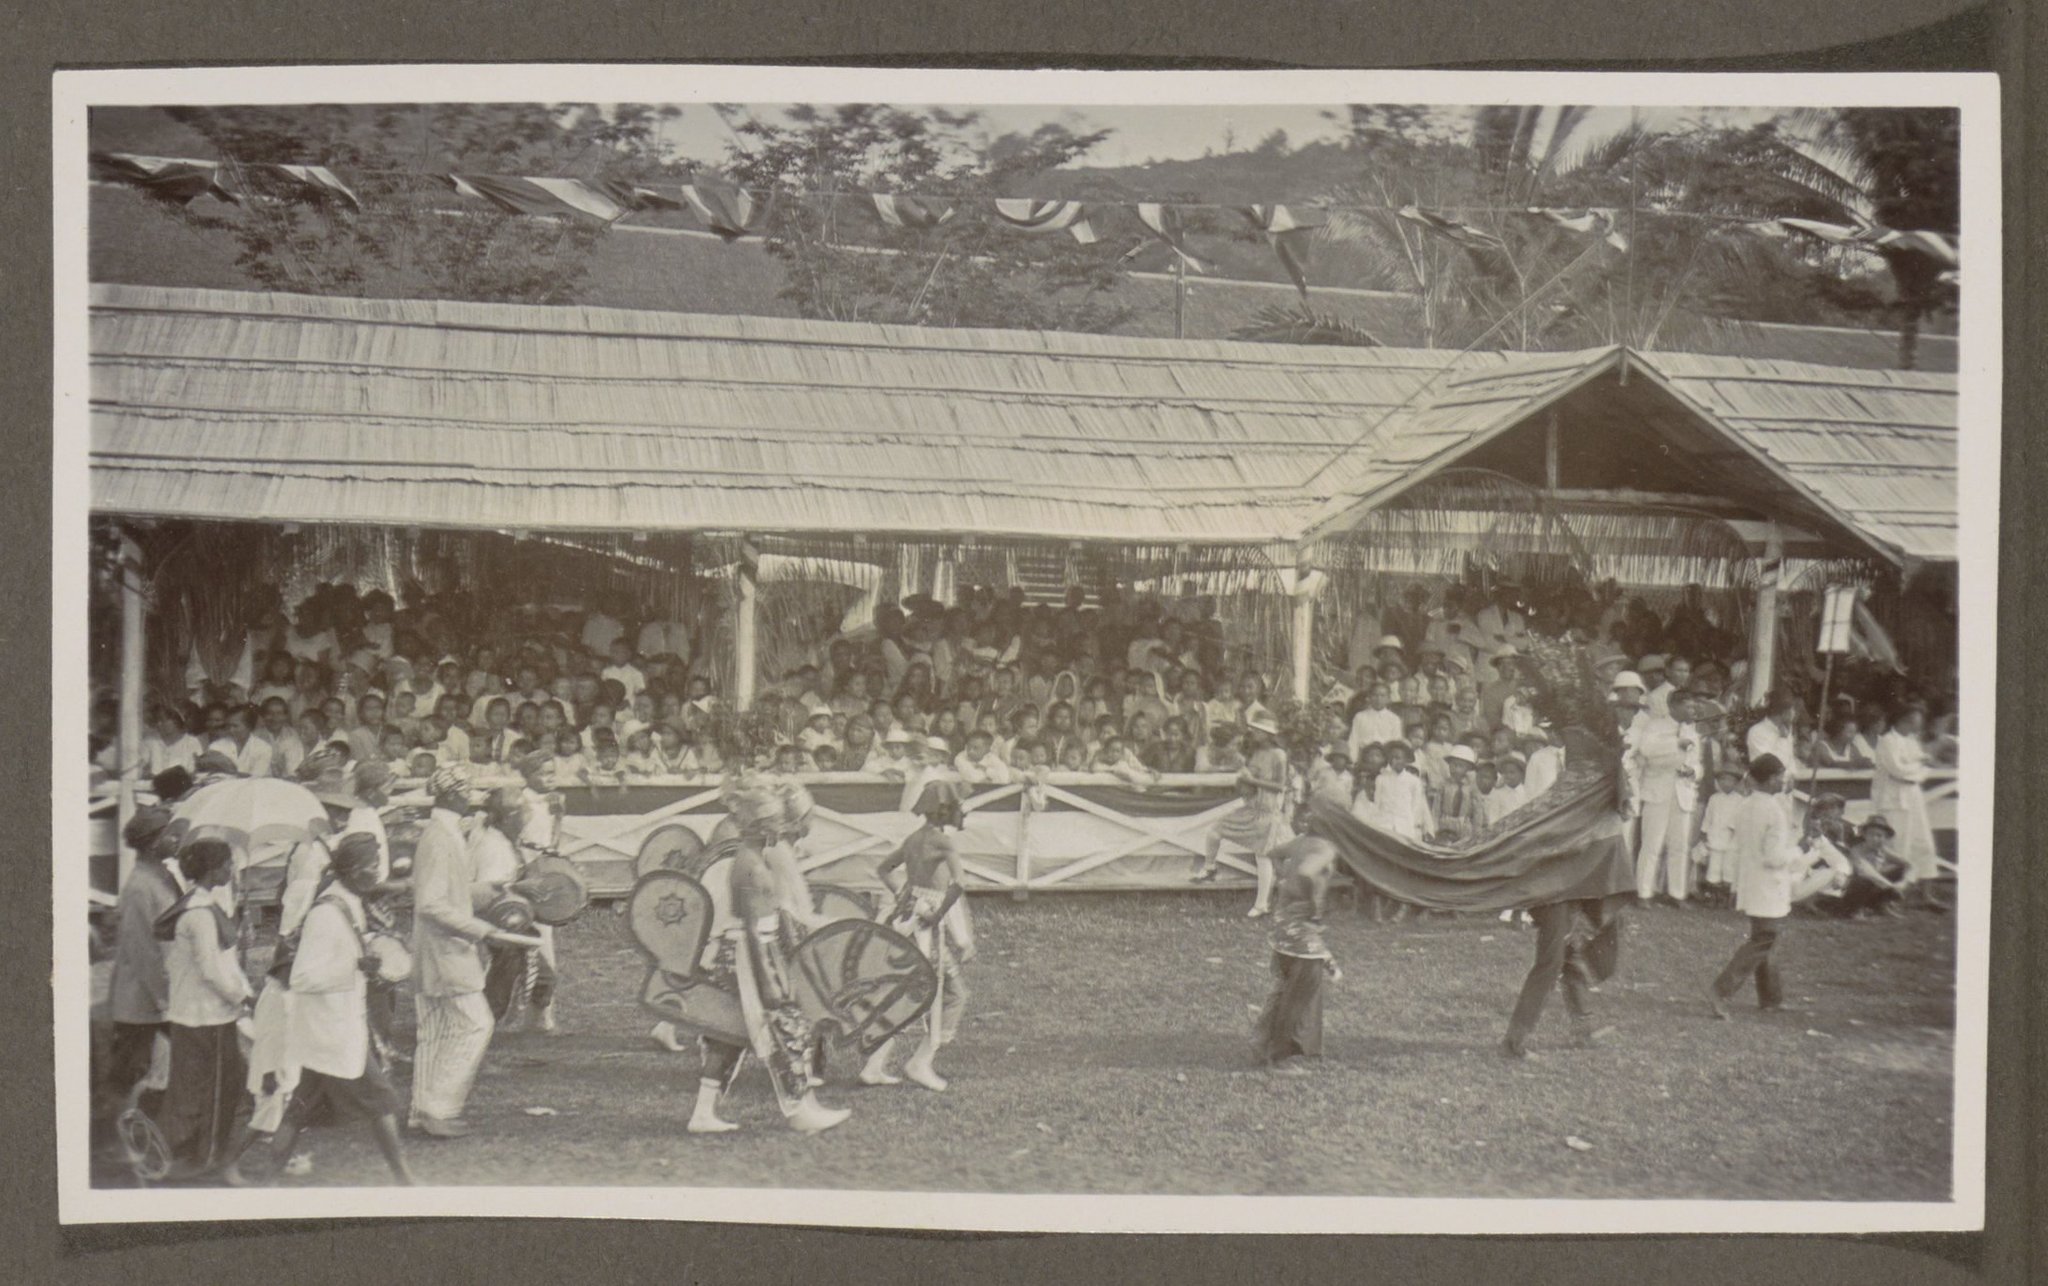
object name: photograph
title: Optocht met deelnemers die ruiters uitbeelden voor een tribune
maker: Anonymous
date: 1920-1930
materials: photographic support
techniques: gelatin silver print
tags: public festivities at birth of royal persons, dutch east indies, the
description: Onderdeel van familiealbum Nederlands-Indië.